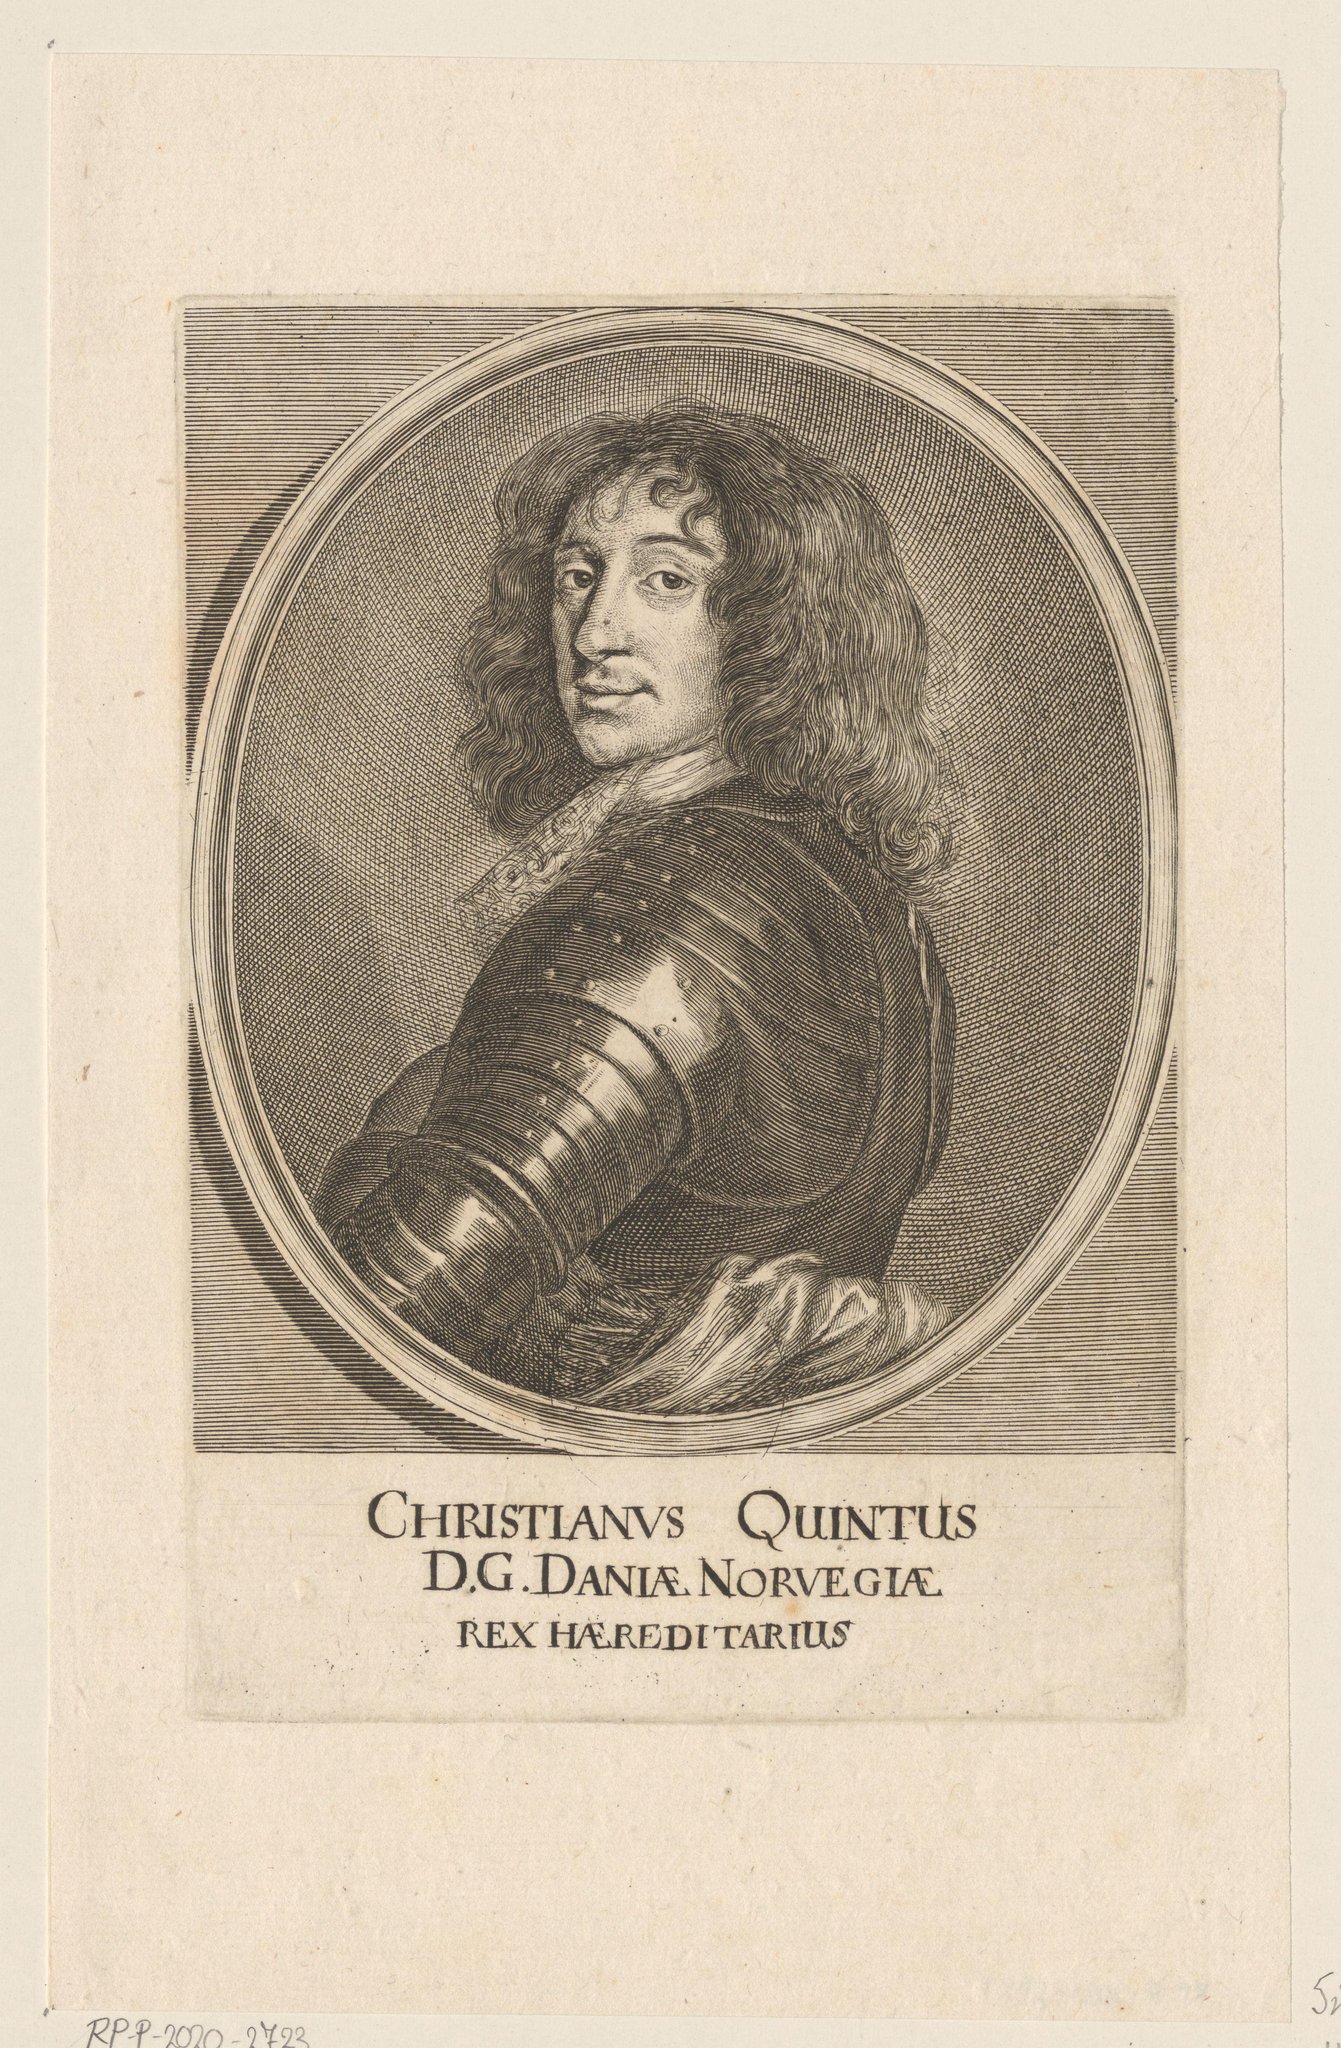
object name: print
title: Portret van Christiaan V, koning van Denemarken en Noorwegen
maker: Anonymous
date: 1682-1691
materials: paper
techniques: engraving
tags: historical persons, king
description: Prent mogelijk uit: Theatrum Europaeum. Frankfurt am Main: erven Matthäus Merian I, 1682, dl. 11. Of uit latere publicaties (1691).